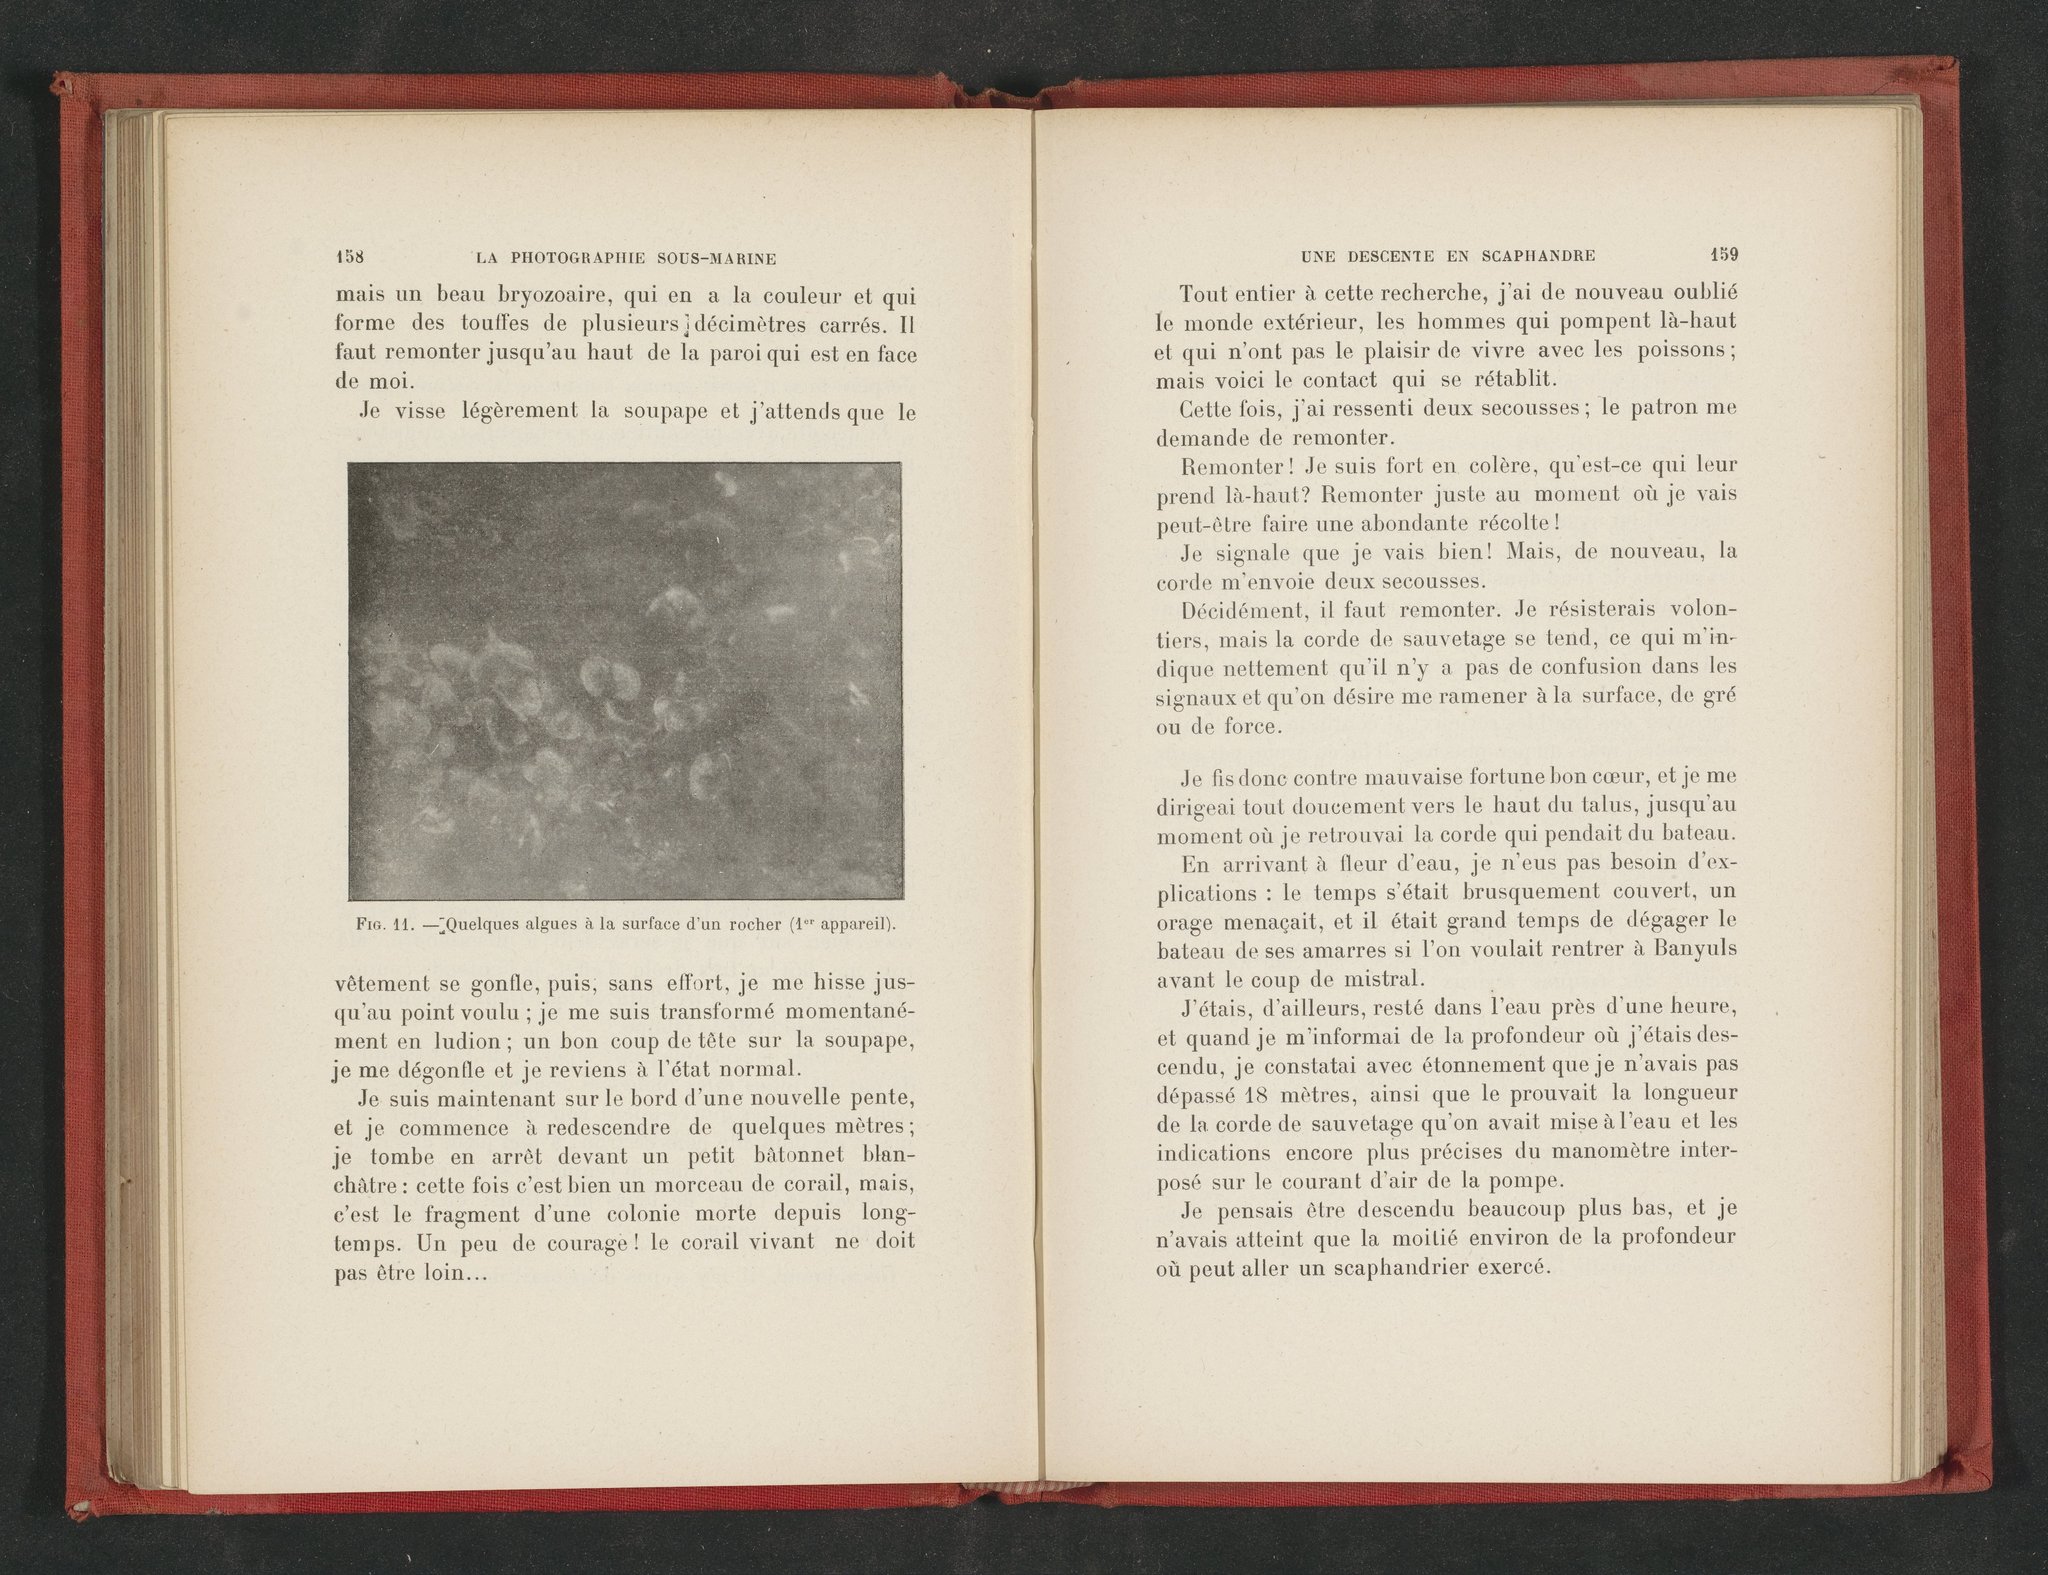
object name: page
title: Algen op een rots onderwater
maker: Anonymous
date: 1890-1900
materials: paper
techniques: autotype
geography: france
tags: algae, seaweed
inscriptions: number: ‘Fig. 11.’